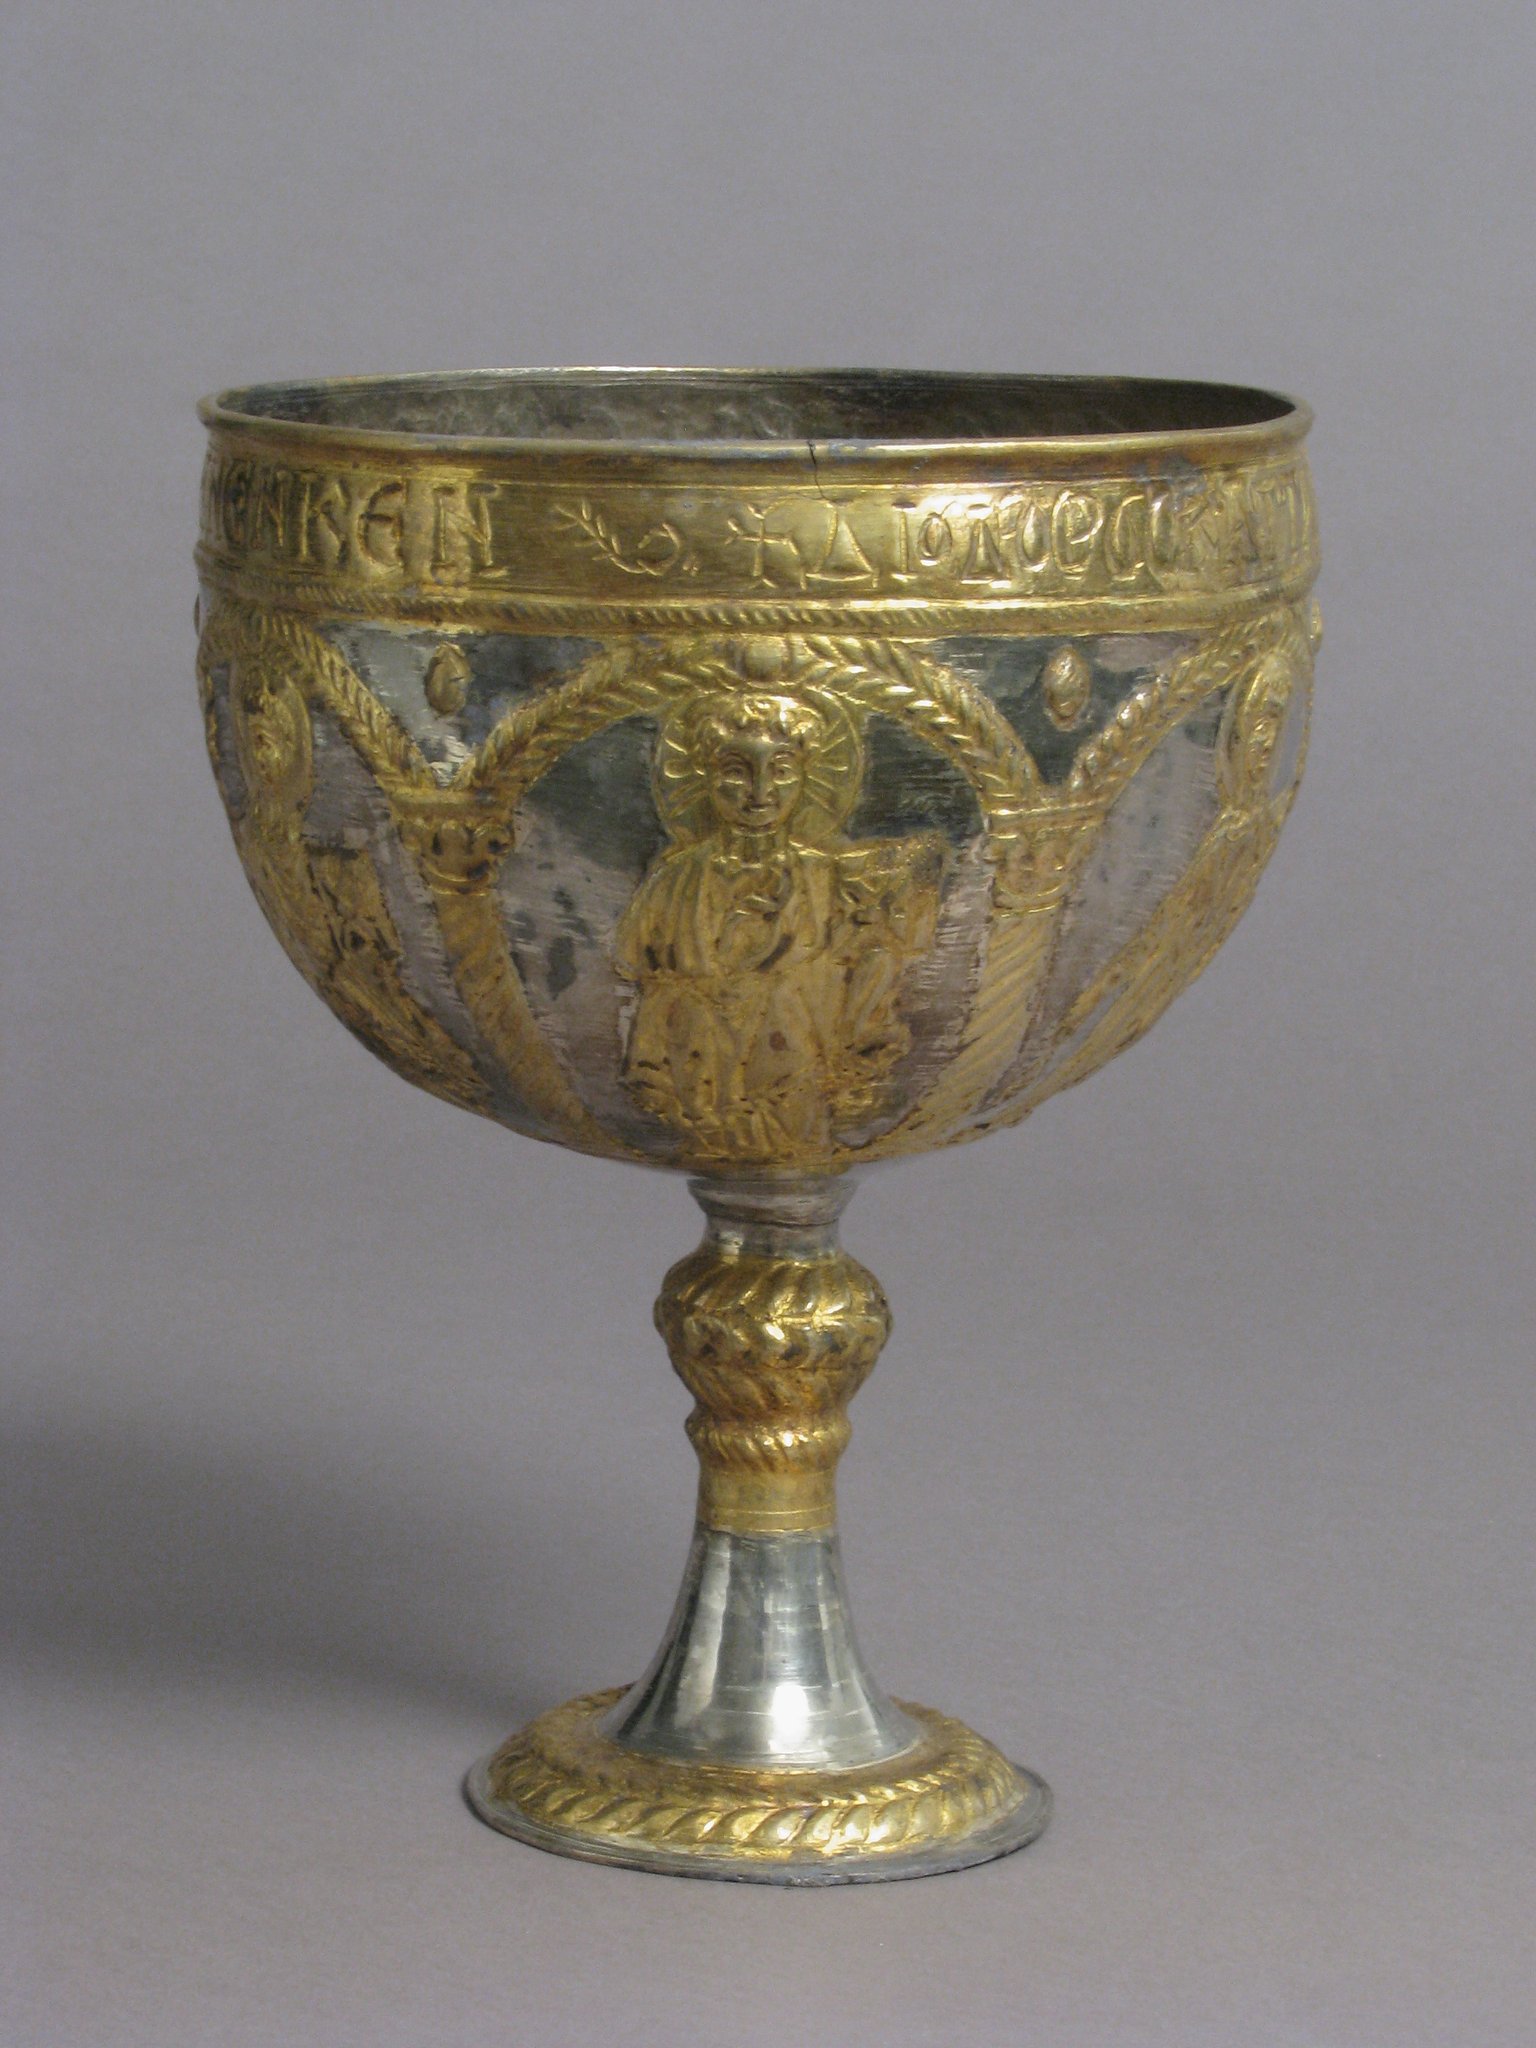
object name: chalice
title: The Attarouthi Treasure - Chalice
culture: byzantine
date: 500-650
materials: gilt silver, silver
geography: syria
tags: christ,virgin mary,saints